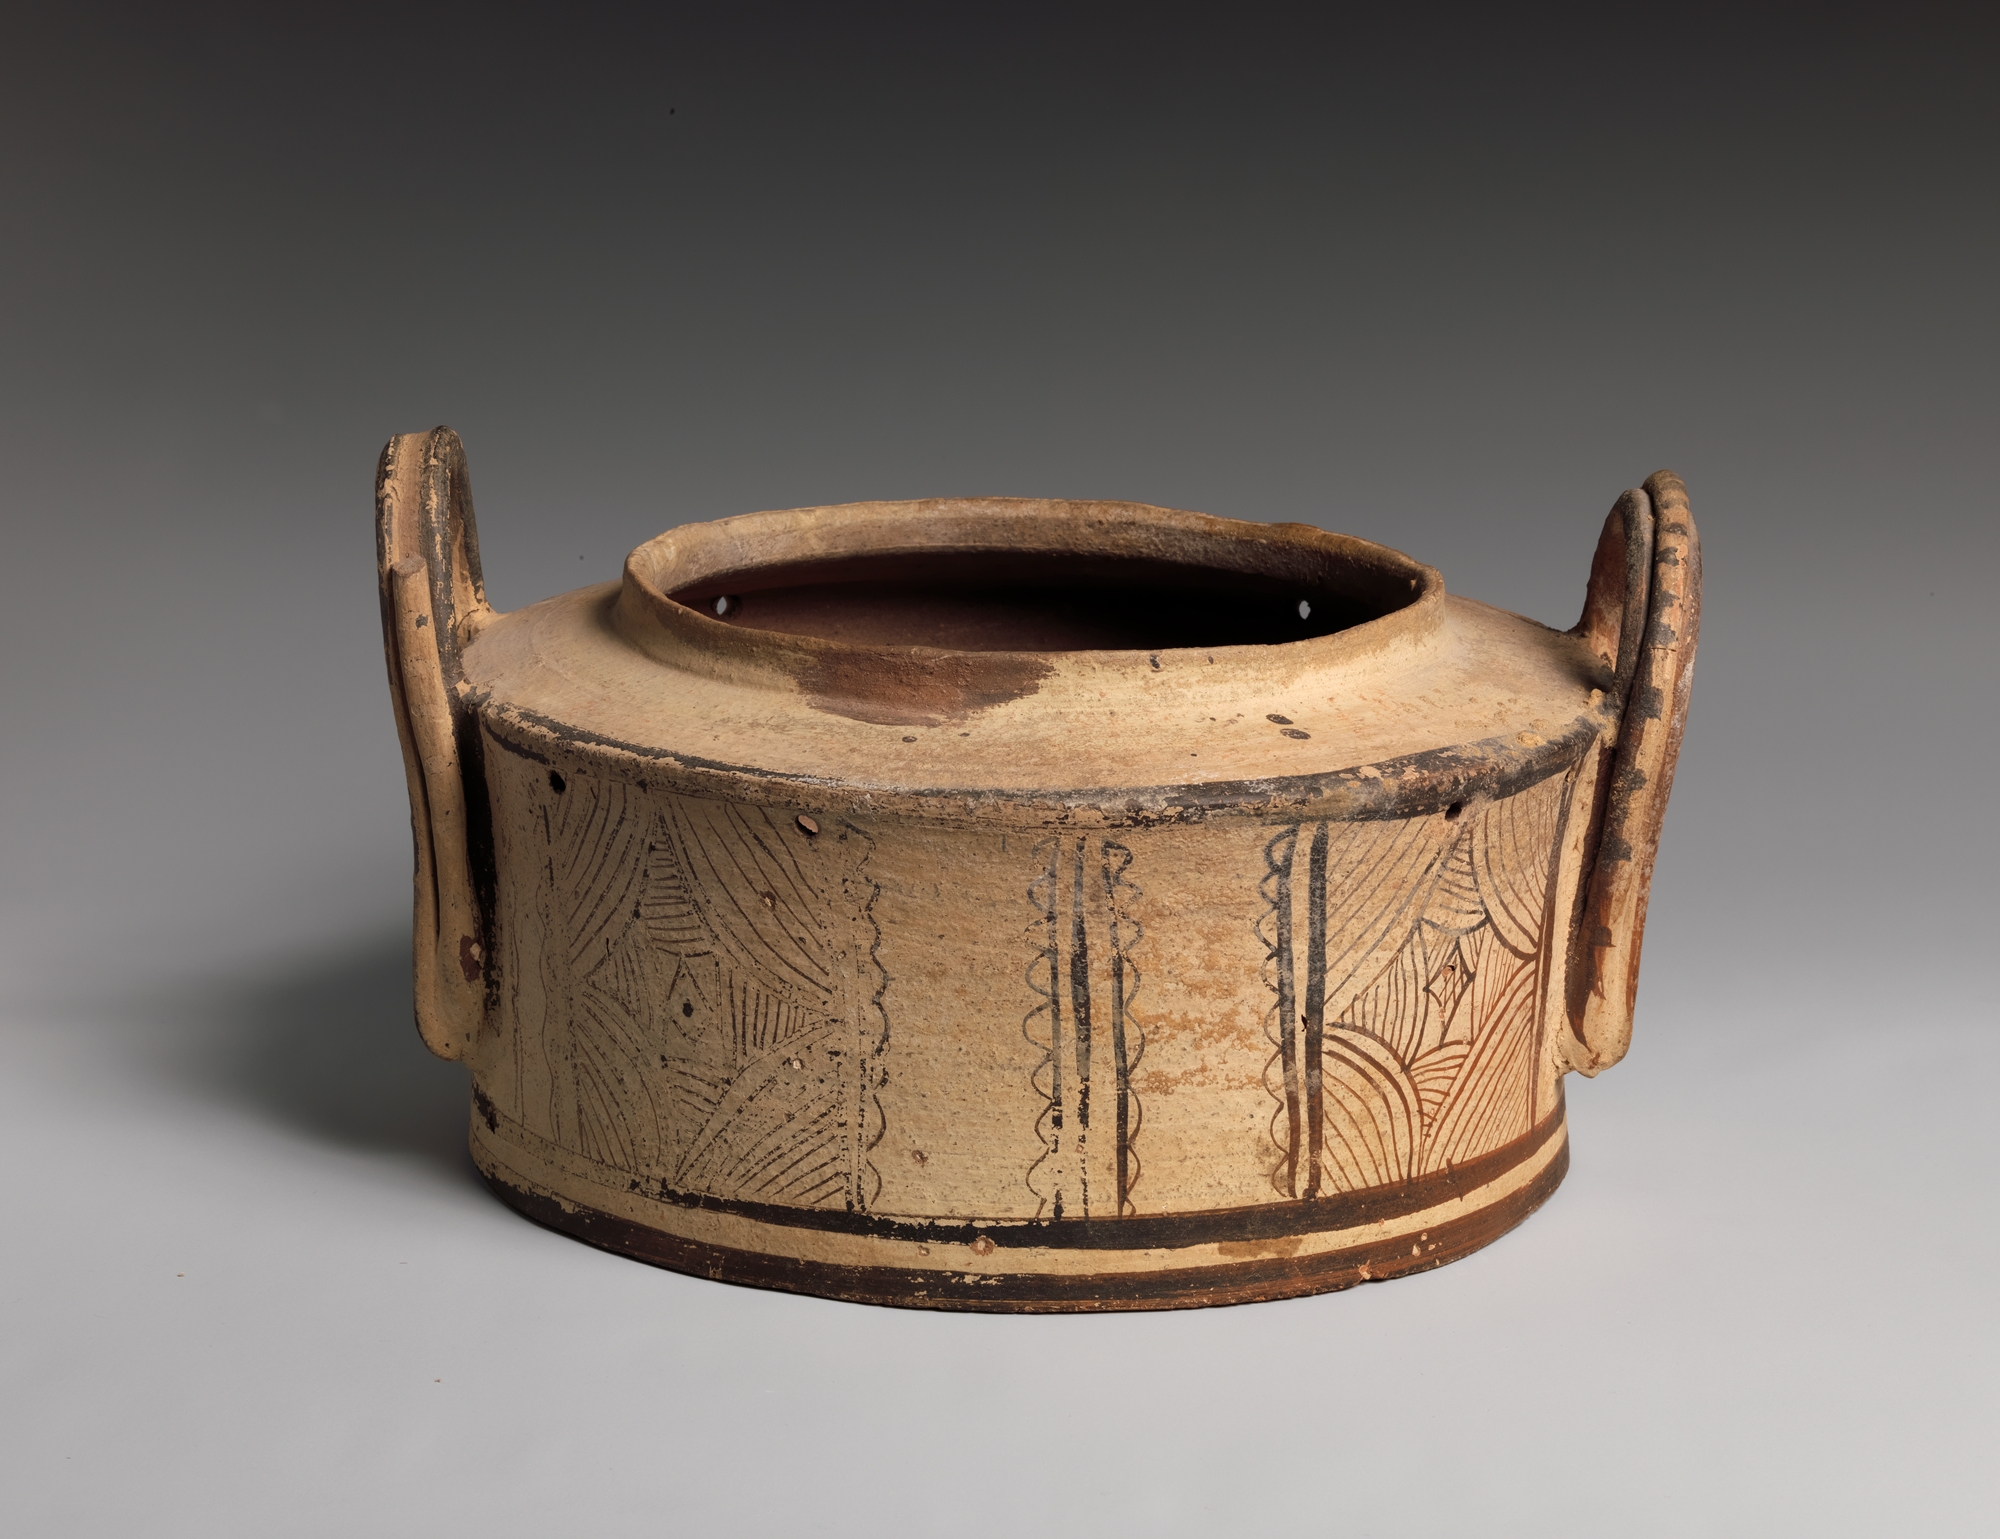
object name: pyxis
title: Terracotta pyxis (cylindrical box)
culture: minoan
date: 1400-1100 BCE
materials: terracotta